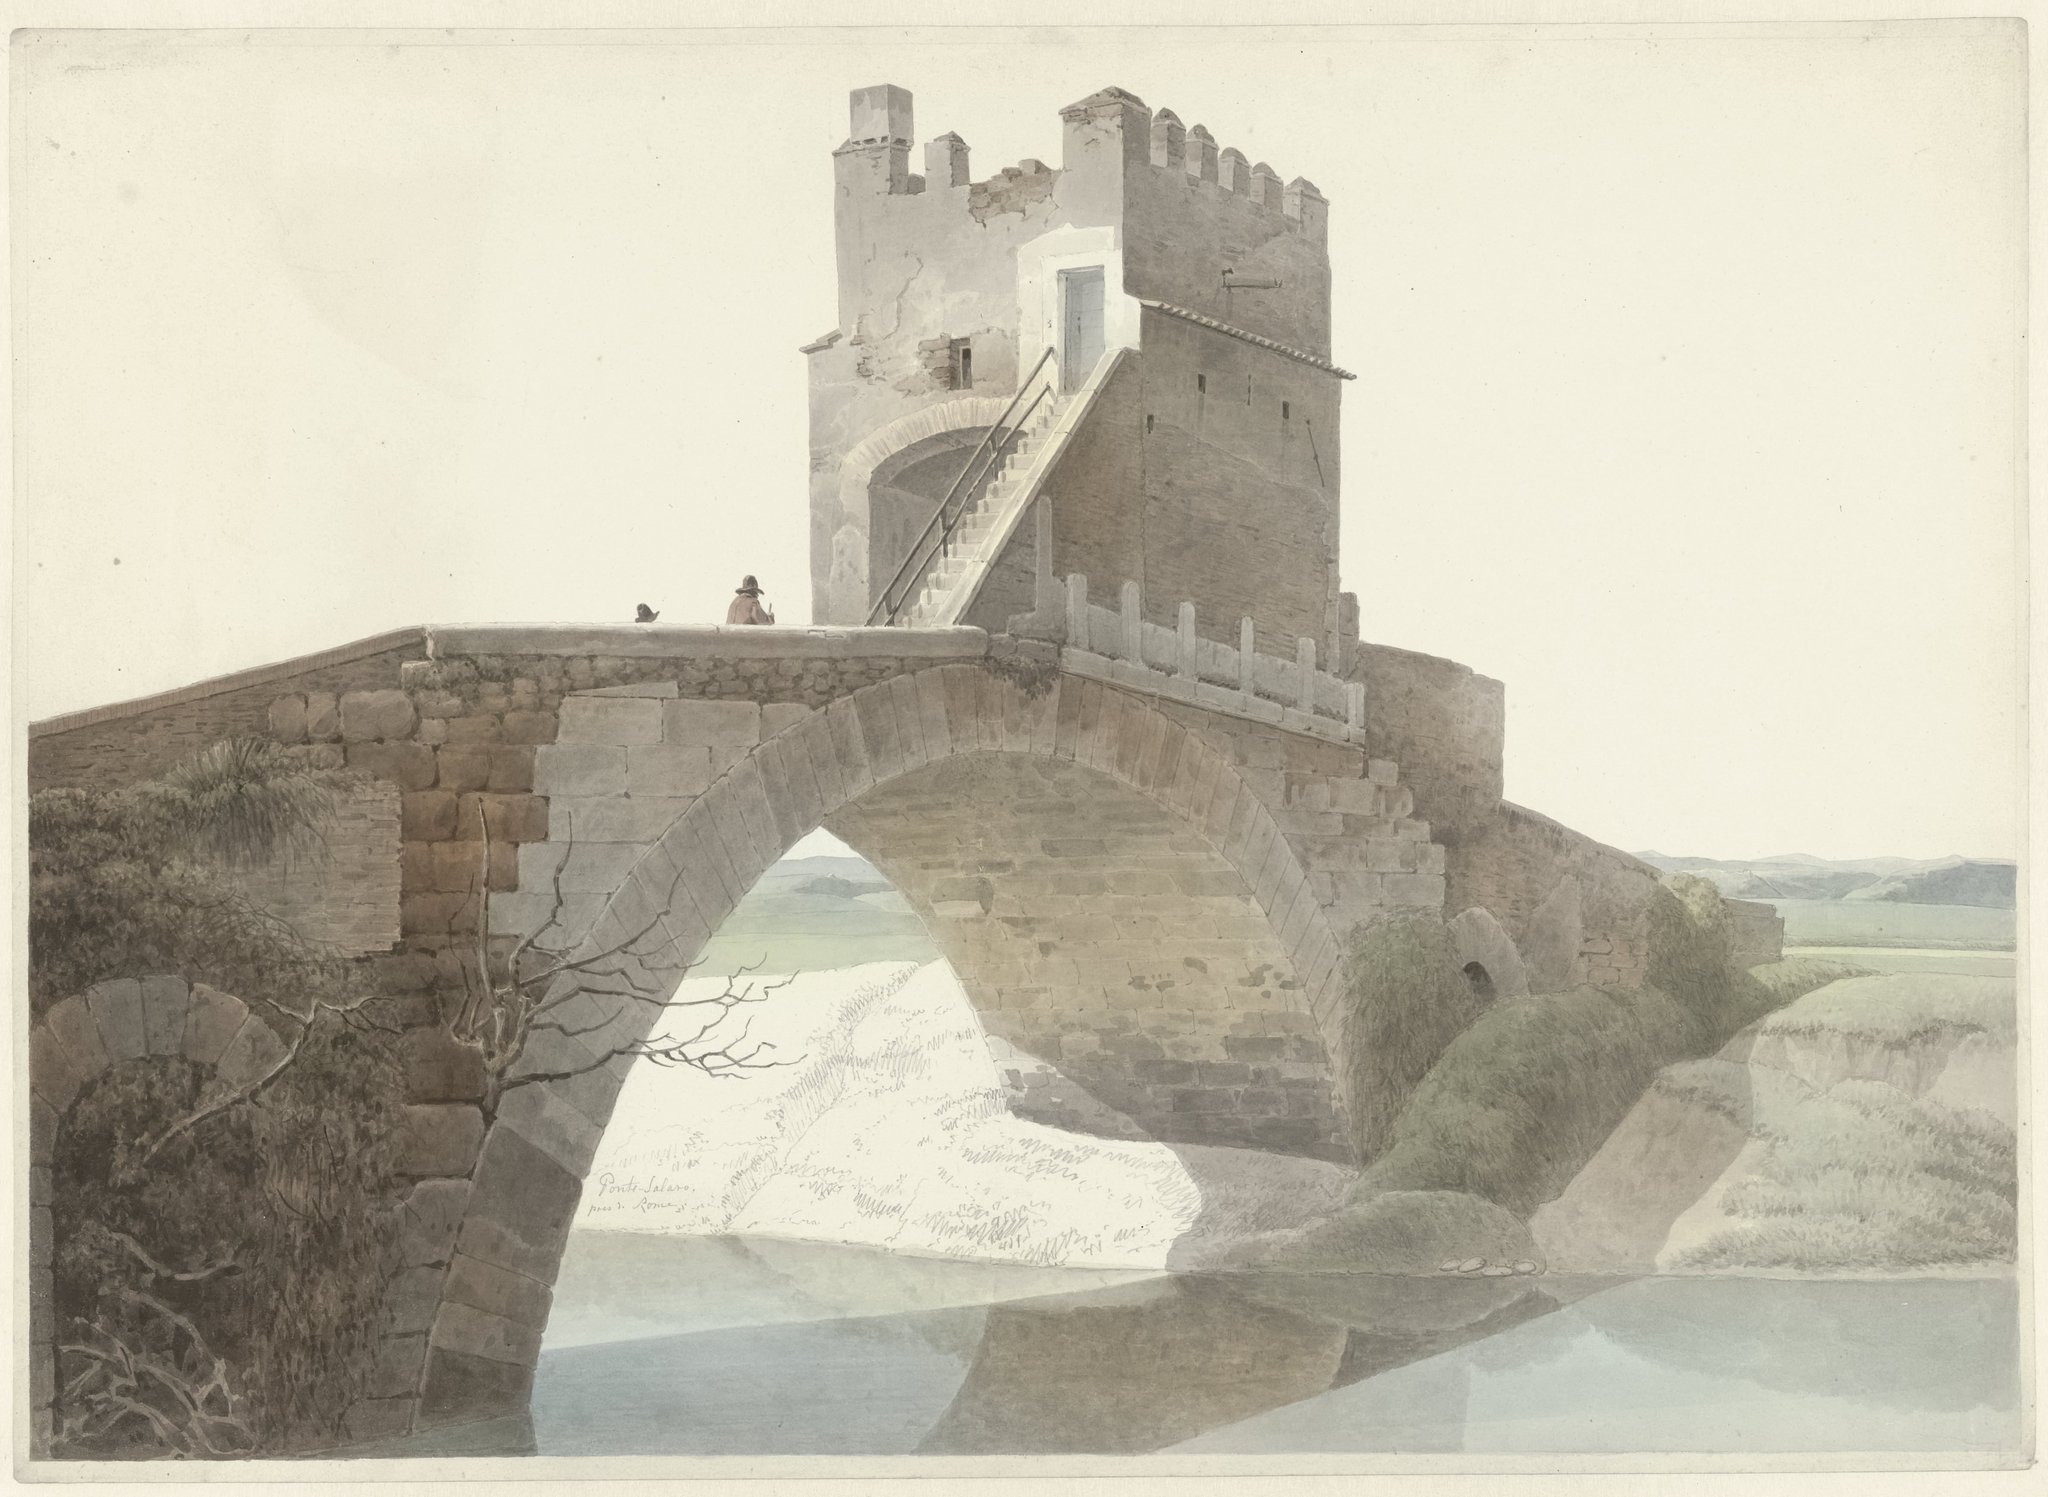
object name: drawing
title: The Ponte Salario, near Rome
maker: josephus augustus knip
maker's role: draughtsman, painter, print maker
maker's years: 1777-1847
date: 1809-1812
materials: graphite, paper, watercolor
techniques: brush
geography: italy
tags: ruin of a building ~ architecture, bridge, rome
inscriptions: inscription: ‘Ponte Salario / pres de Rome’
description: The original Ponte Salario, spanning the River Aniene north of Rome, was built by the Etruscans. This road bridge was an important link in the northern route to Rome and so was battered repeatedly in the course of its long history. The present bridge dates from 1930; all remains of the old bridge have vanished.